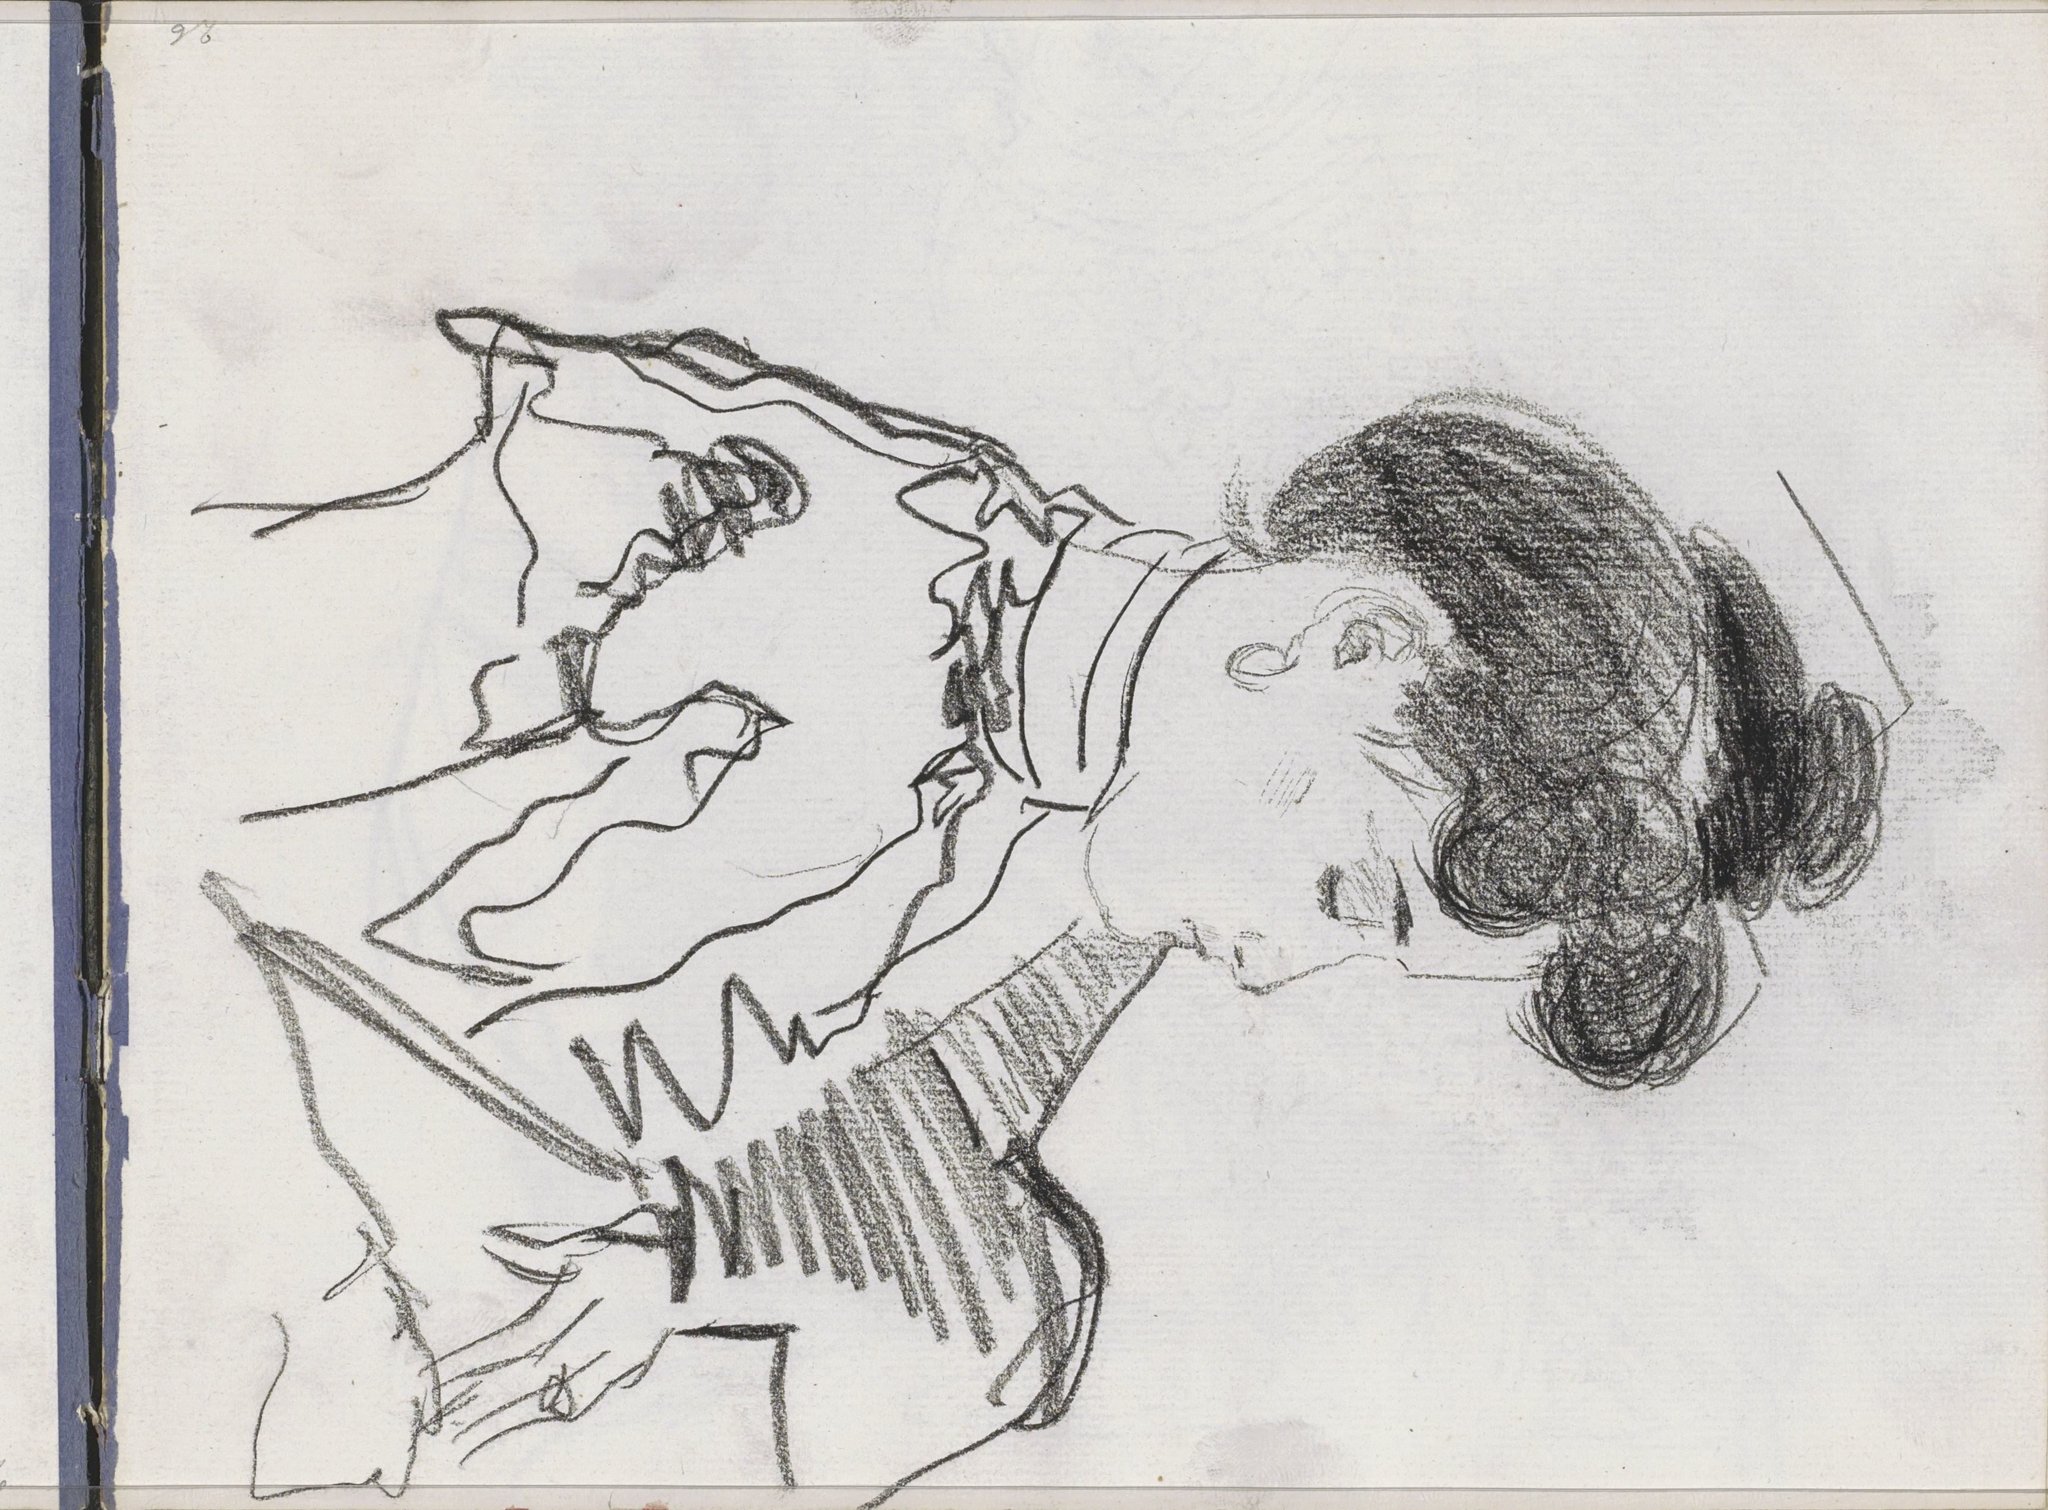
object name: sketchbook leaf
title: Zittende vrouw, in profiel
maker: isaac israels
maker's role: draughtsman, painter, print maker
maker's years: 1865-1934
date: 1875-1934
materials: chalk, paper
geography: the hague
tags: adult woman (+ sitting)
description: Blad 6 recto uit schetsboek XXII met 30 bladen.